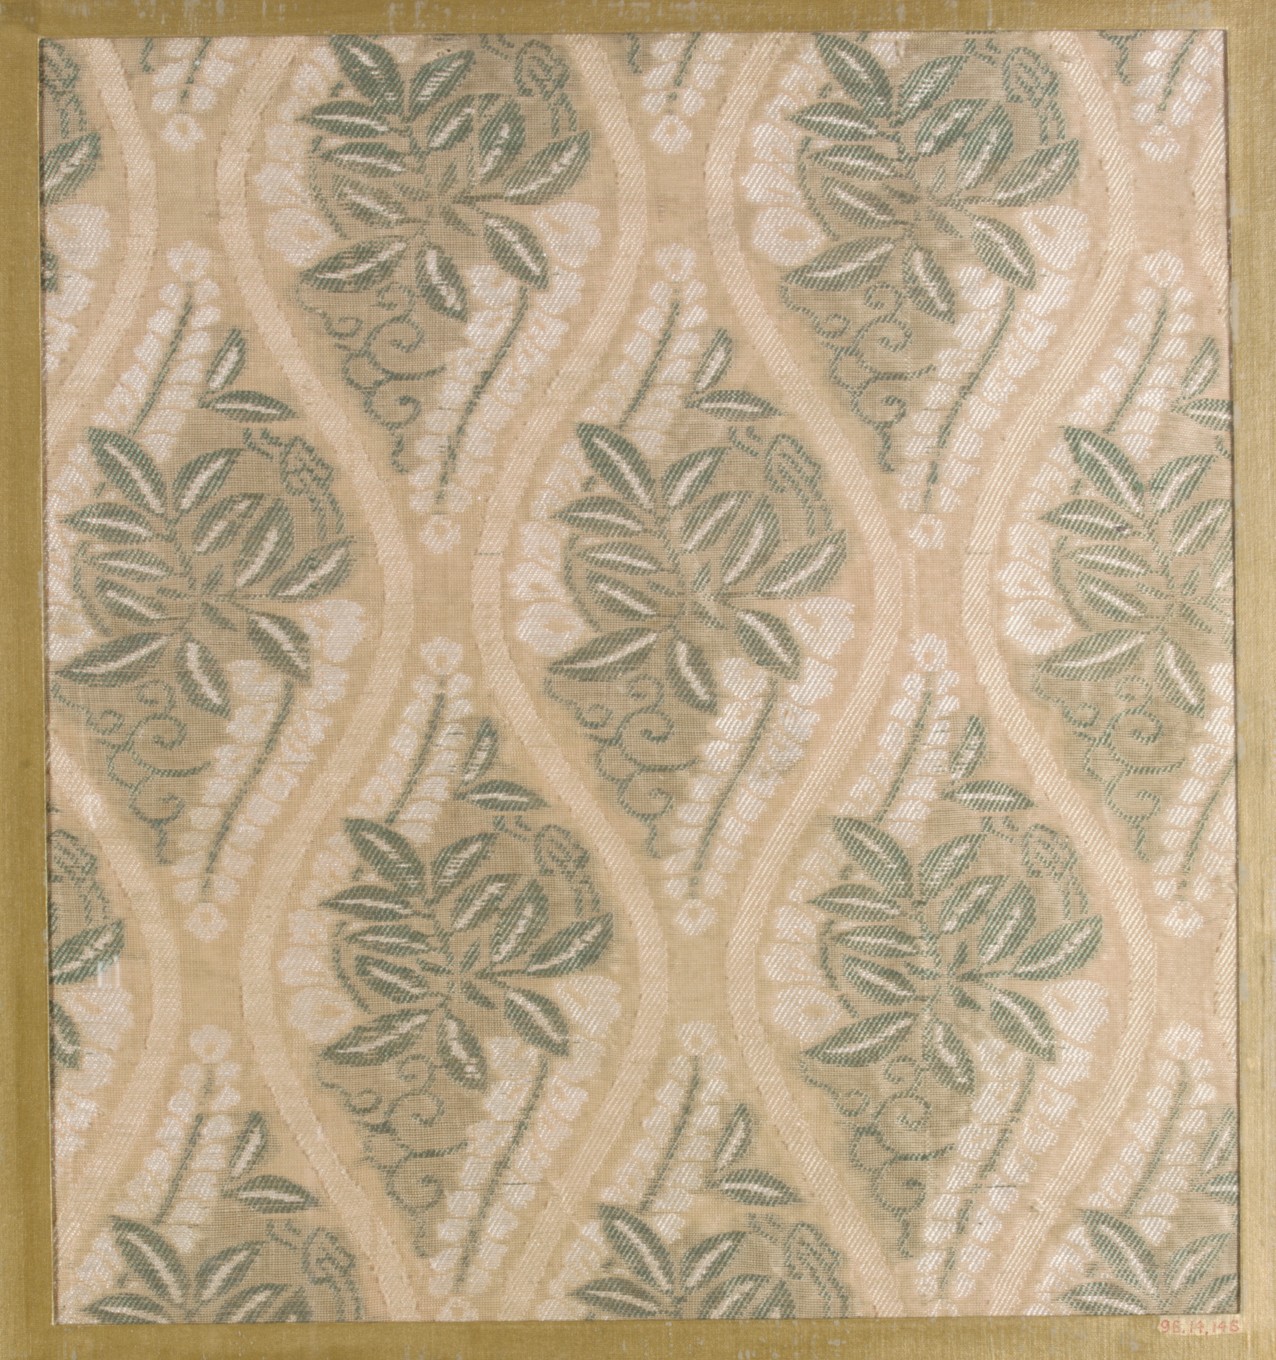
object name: piece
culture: japanese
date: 1801-1900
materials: silk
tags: leaves